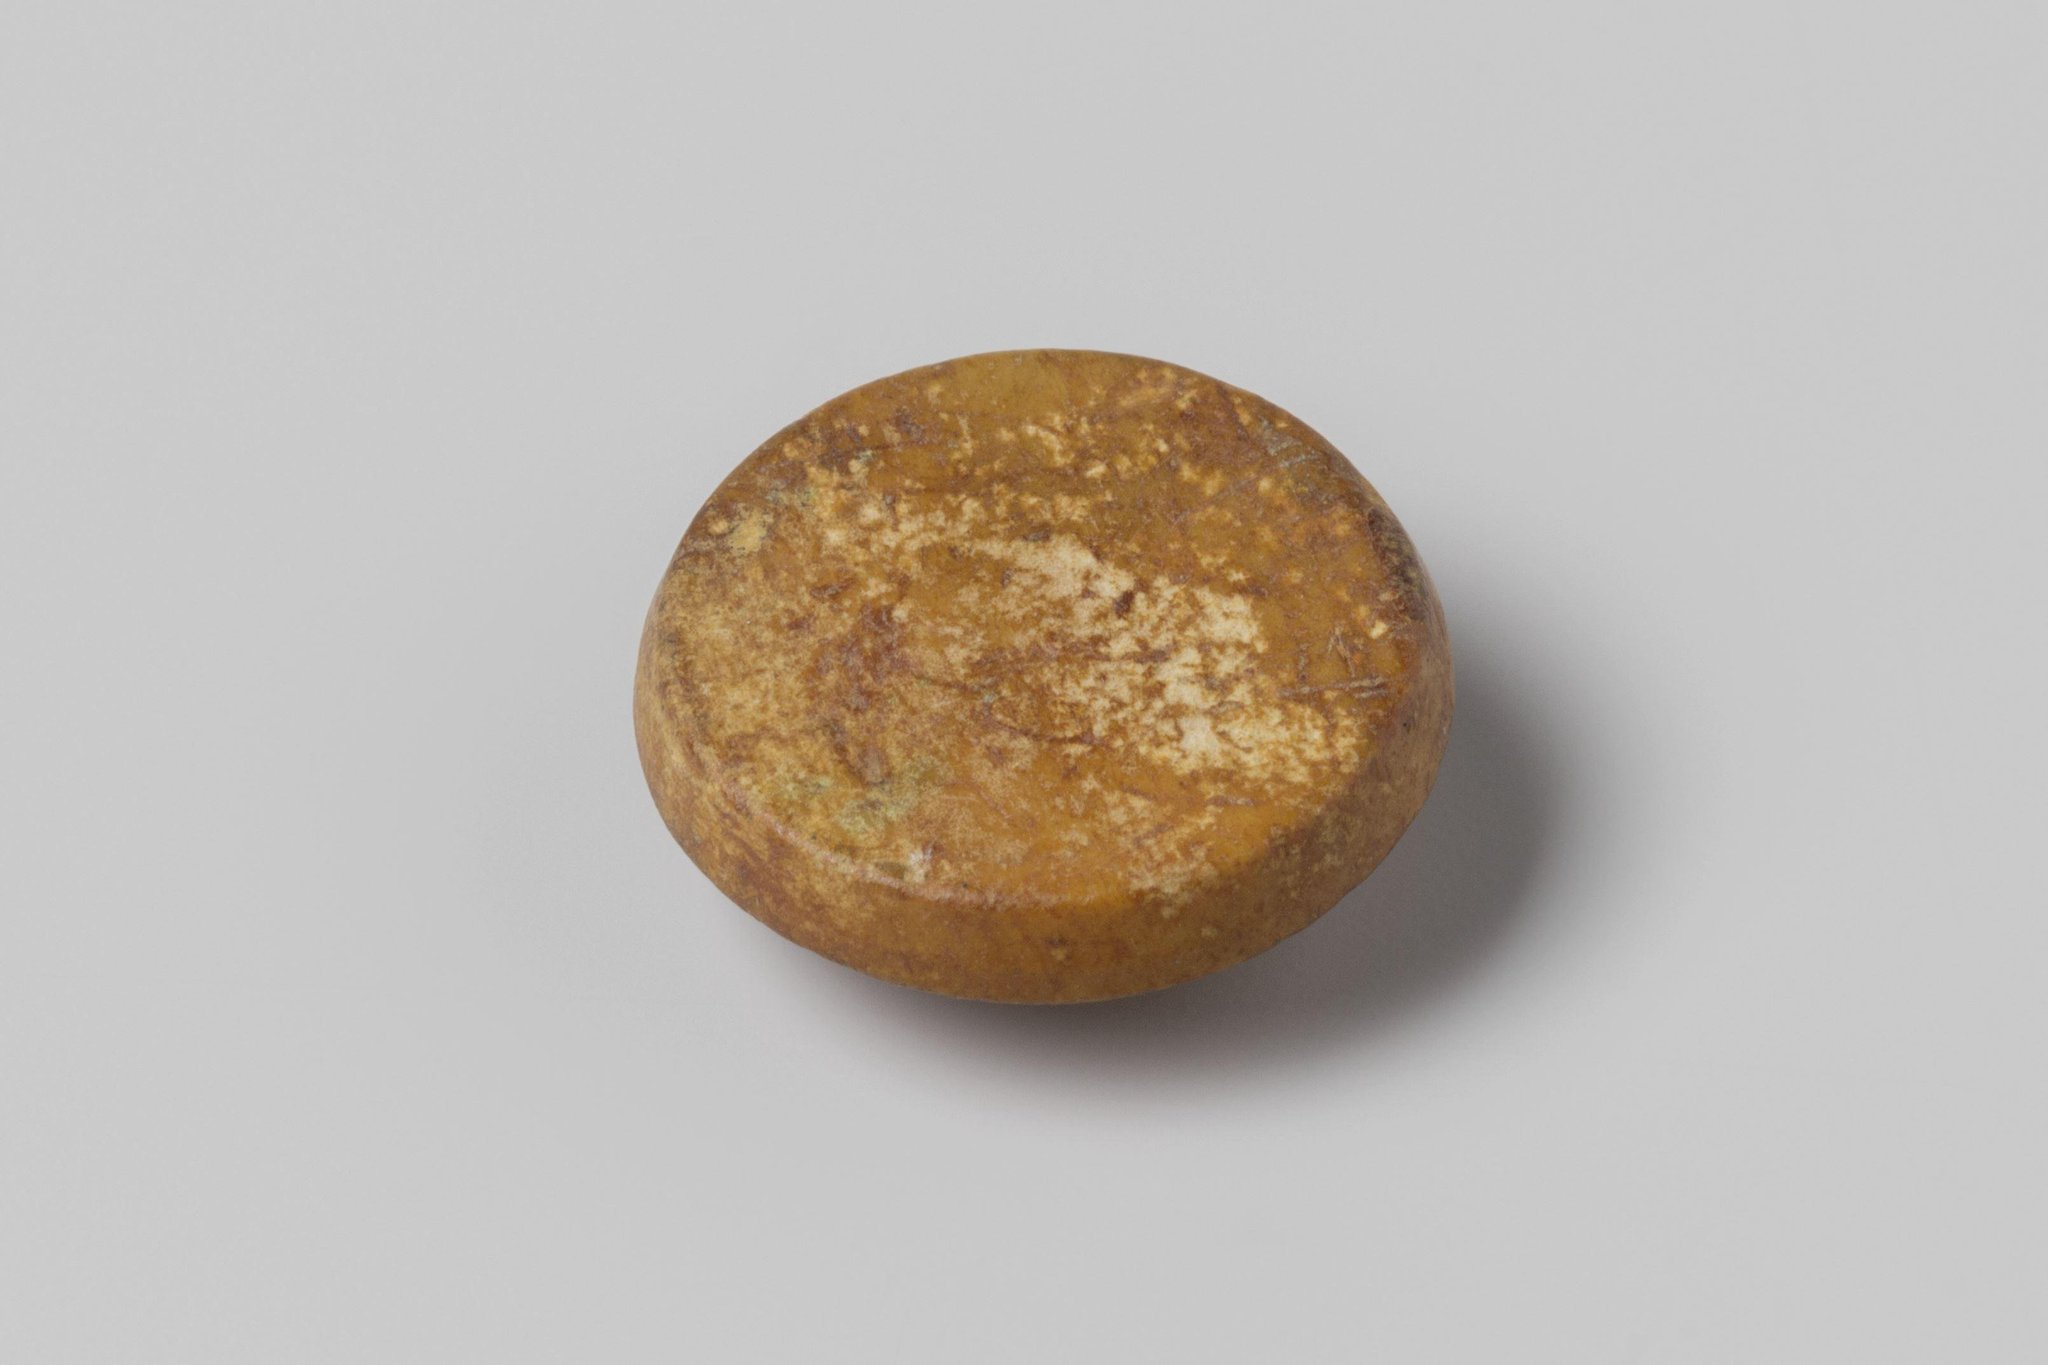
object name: button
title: Knoop uit het wrak van de Oost-Indiëvaarder Hollandia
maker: Anonymous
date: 1700-1743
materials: bone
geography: netherlands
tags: verenigde oostindische compagnie, hollandia (schip), annet